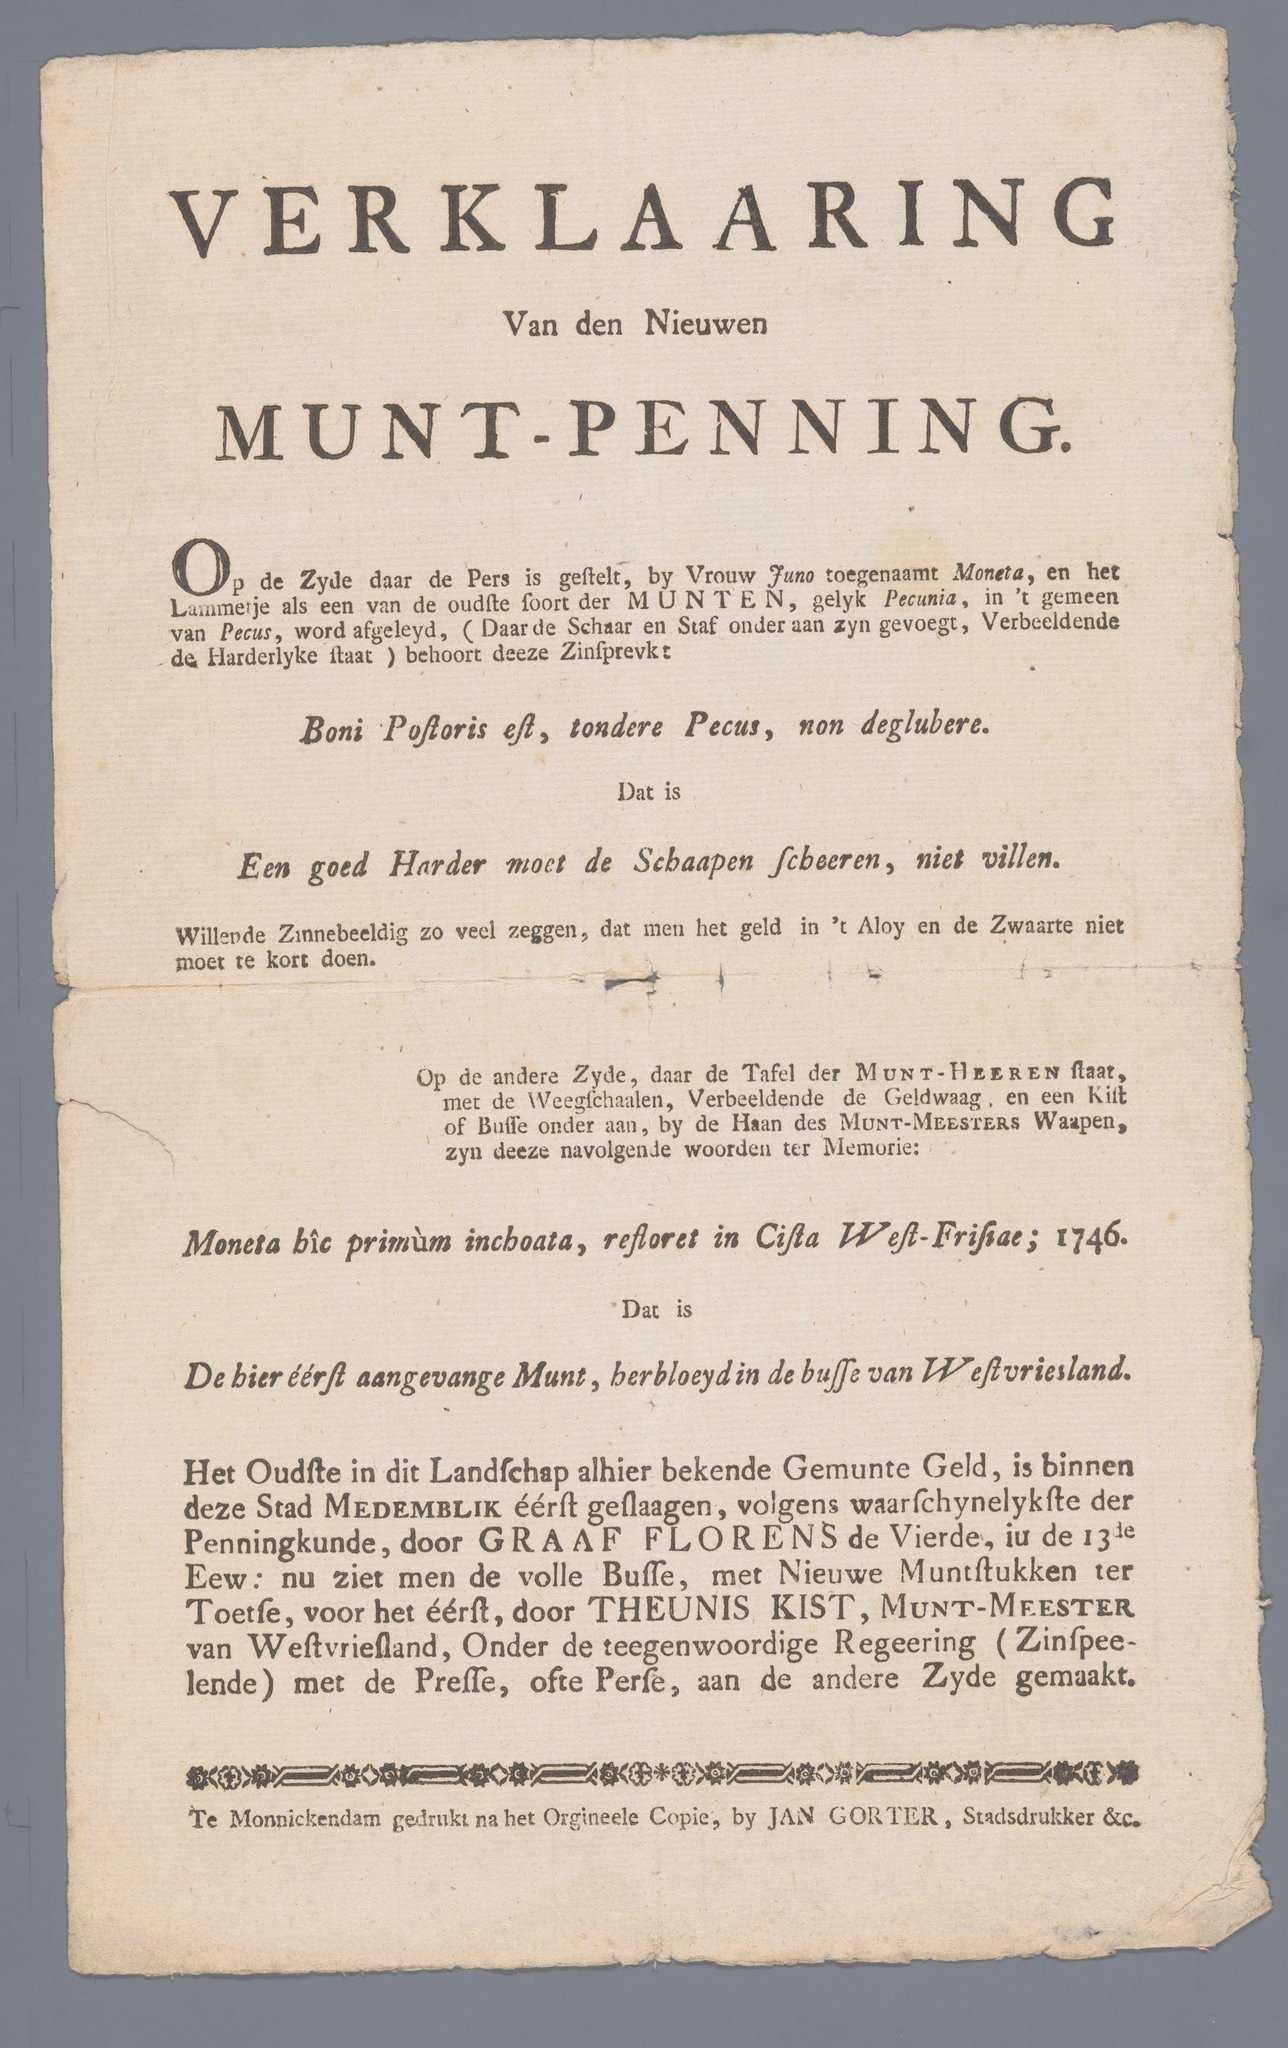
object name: pamphlet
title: Verklaring van de penning door Theunis Kist geslagen op het openen van de Westfriese muntbus te Medemblik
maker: Anonymous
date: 1746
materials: paper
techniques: printing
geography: monnickendam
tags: harderwijk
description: eenzijdig, rechthoekig papier met opschrift, gedrukt in zwarte inkt